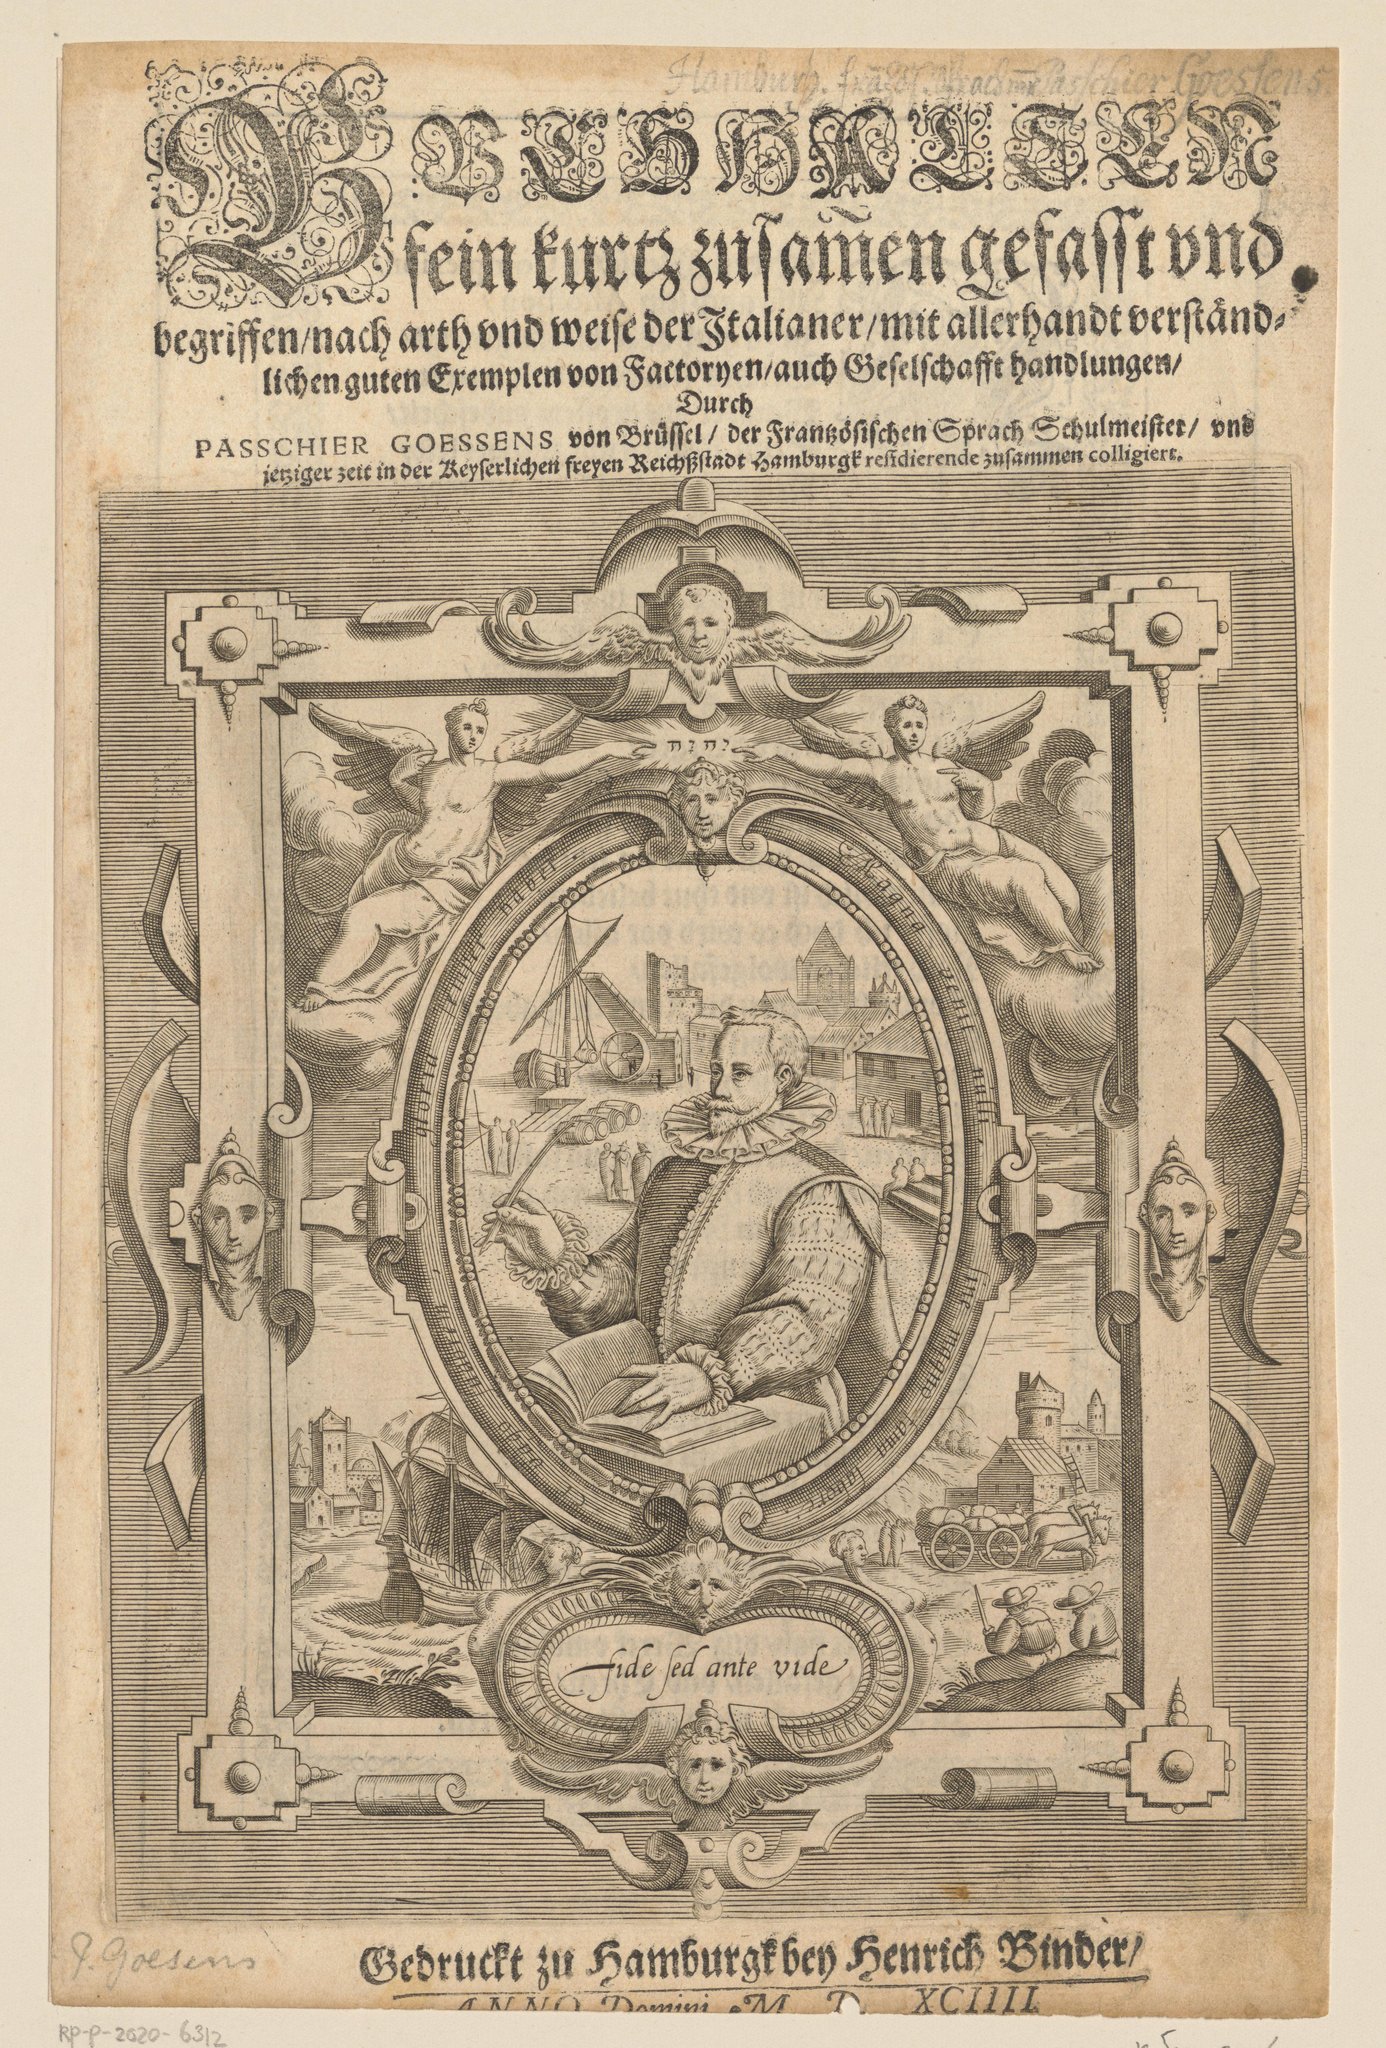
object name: print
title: Titelpagina voor: Passchier Goessens, Buchhalten fein kurtz zusammengefaßt nach arth der Italianer, 1594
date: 1594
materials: paper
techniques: engraving, letterpress printing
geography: hamburg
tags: historical persons, portrait of a writer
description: Titelpagina voor: Goessens, Passchier. Buchhalten fein kurtz zusammengefaßt nach arth der Italianer. Hamburg: Heinrich Binder, 1594.